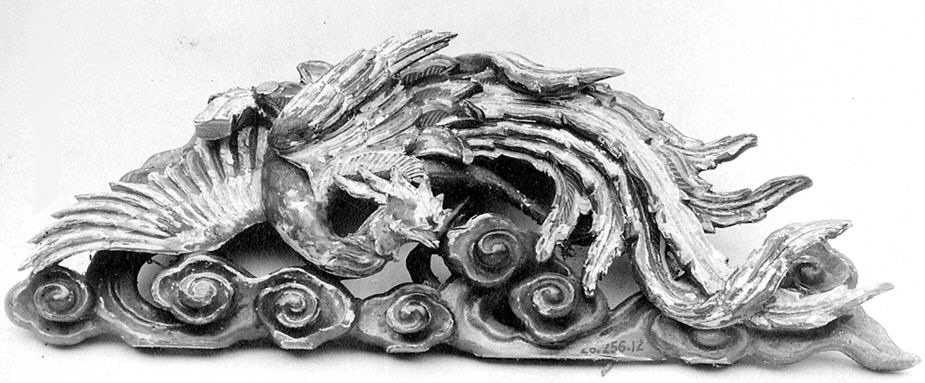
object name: rama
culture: japanese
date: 1701-1800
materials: wood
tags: birds